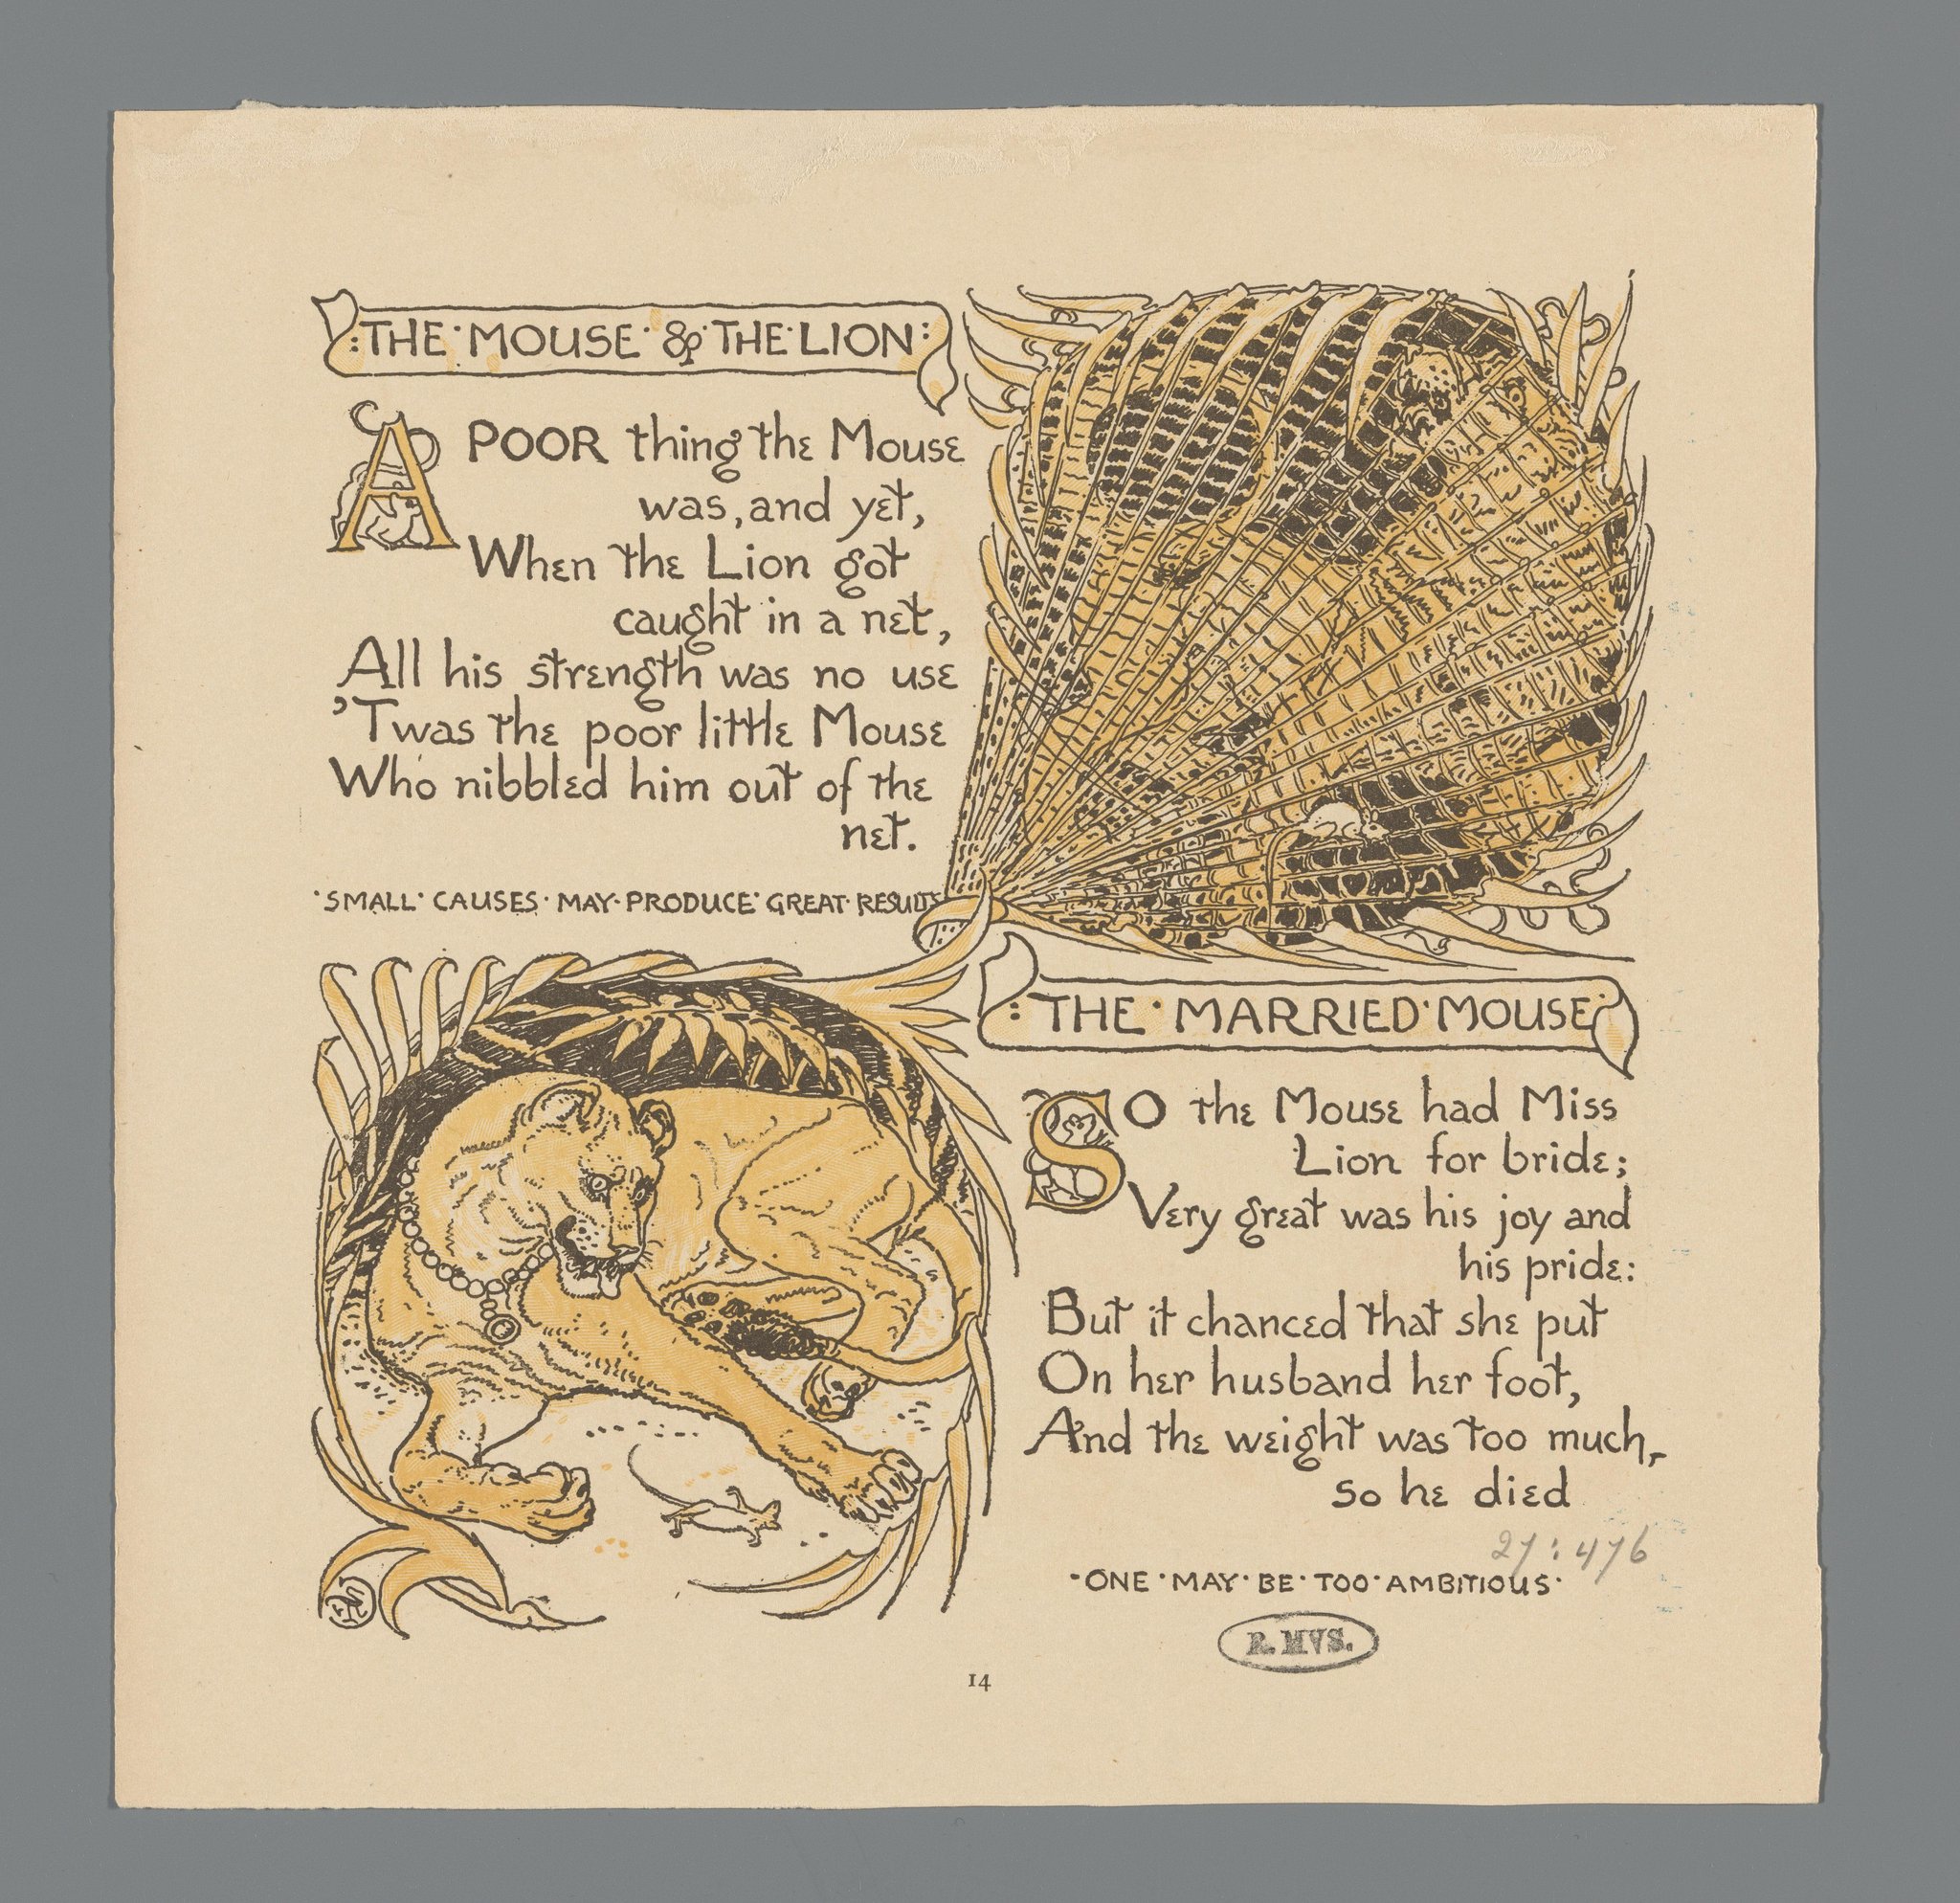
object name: book illustration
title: The married mouse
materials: paper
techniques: wood engraving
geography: london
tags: rodents: mouse, container of textile material: bag, sack, beasts of prey, predatory animals: lion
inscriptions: collector's mark: Lugt 2228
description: Prent uit: The baby's own Aesop being the fables condensed in rhyme. Londen: Routledge & Sons, 1887. Of een latere uitgave.